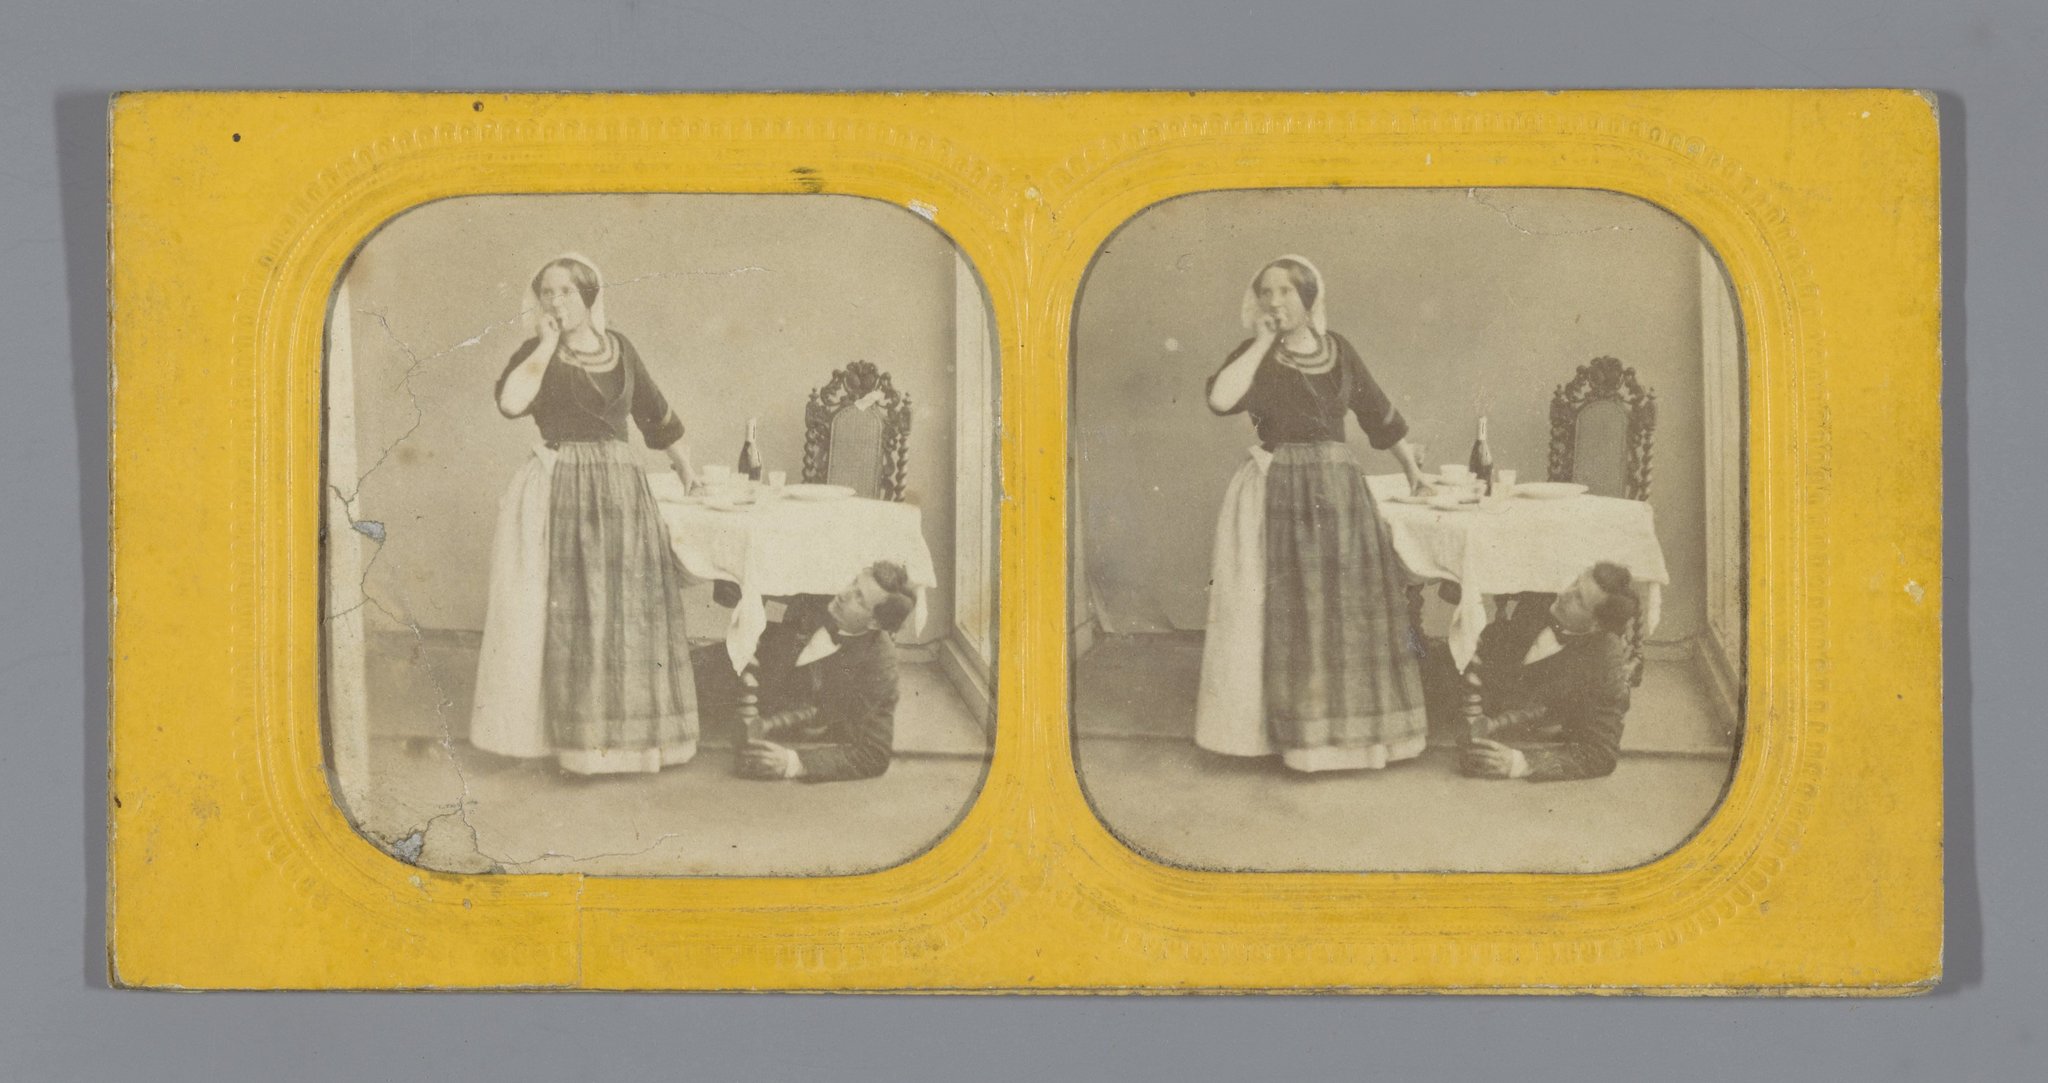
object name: tissue stereograph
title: Man verstopt zich onder tafel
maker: Anonymous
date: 1855-1875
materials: cardboard, paper, photographic support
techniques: albumen print, cutting, hand coloring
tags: hiding, hiding oneself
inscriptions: name: ‘Henny’